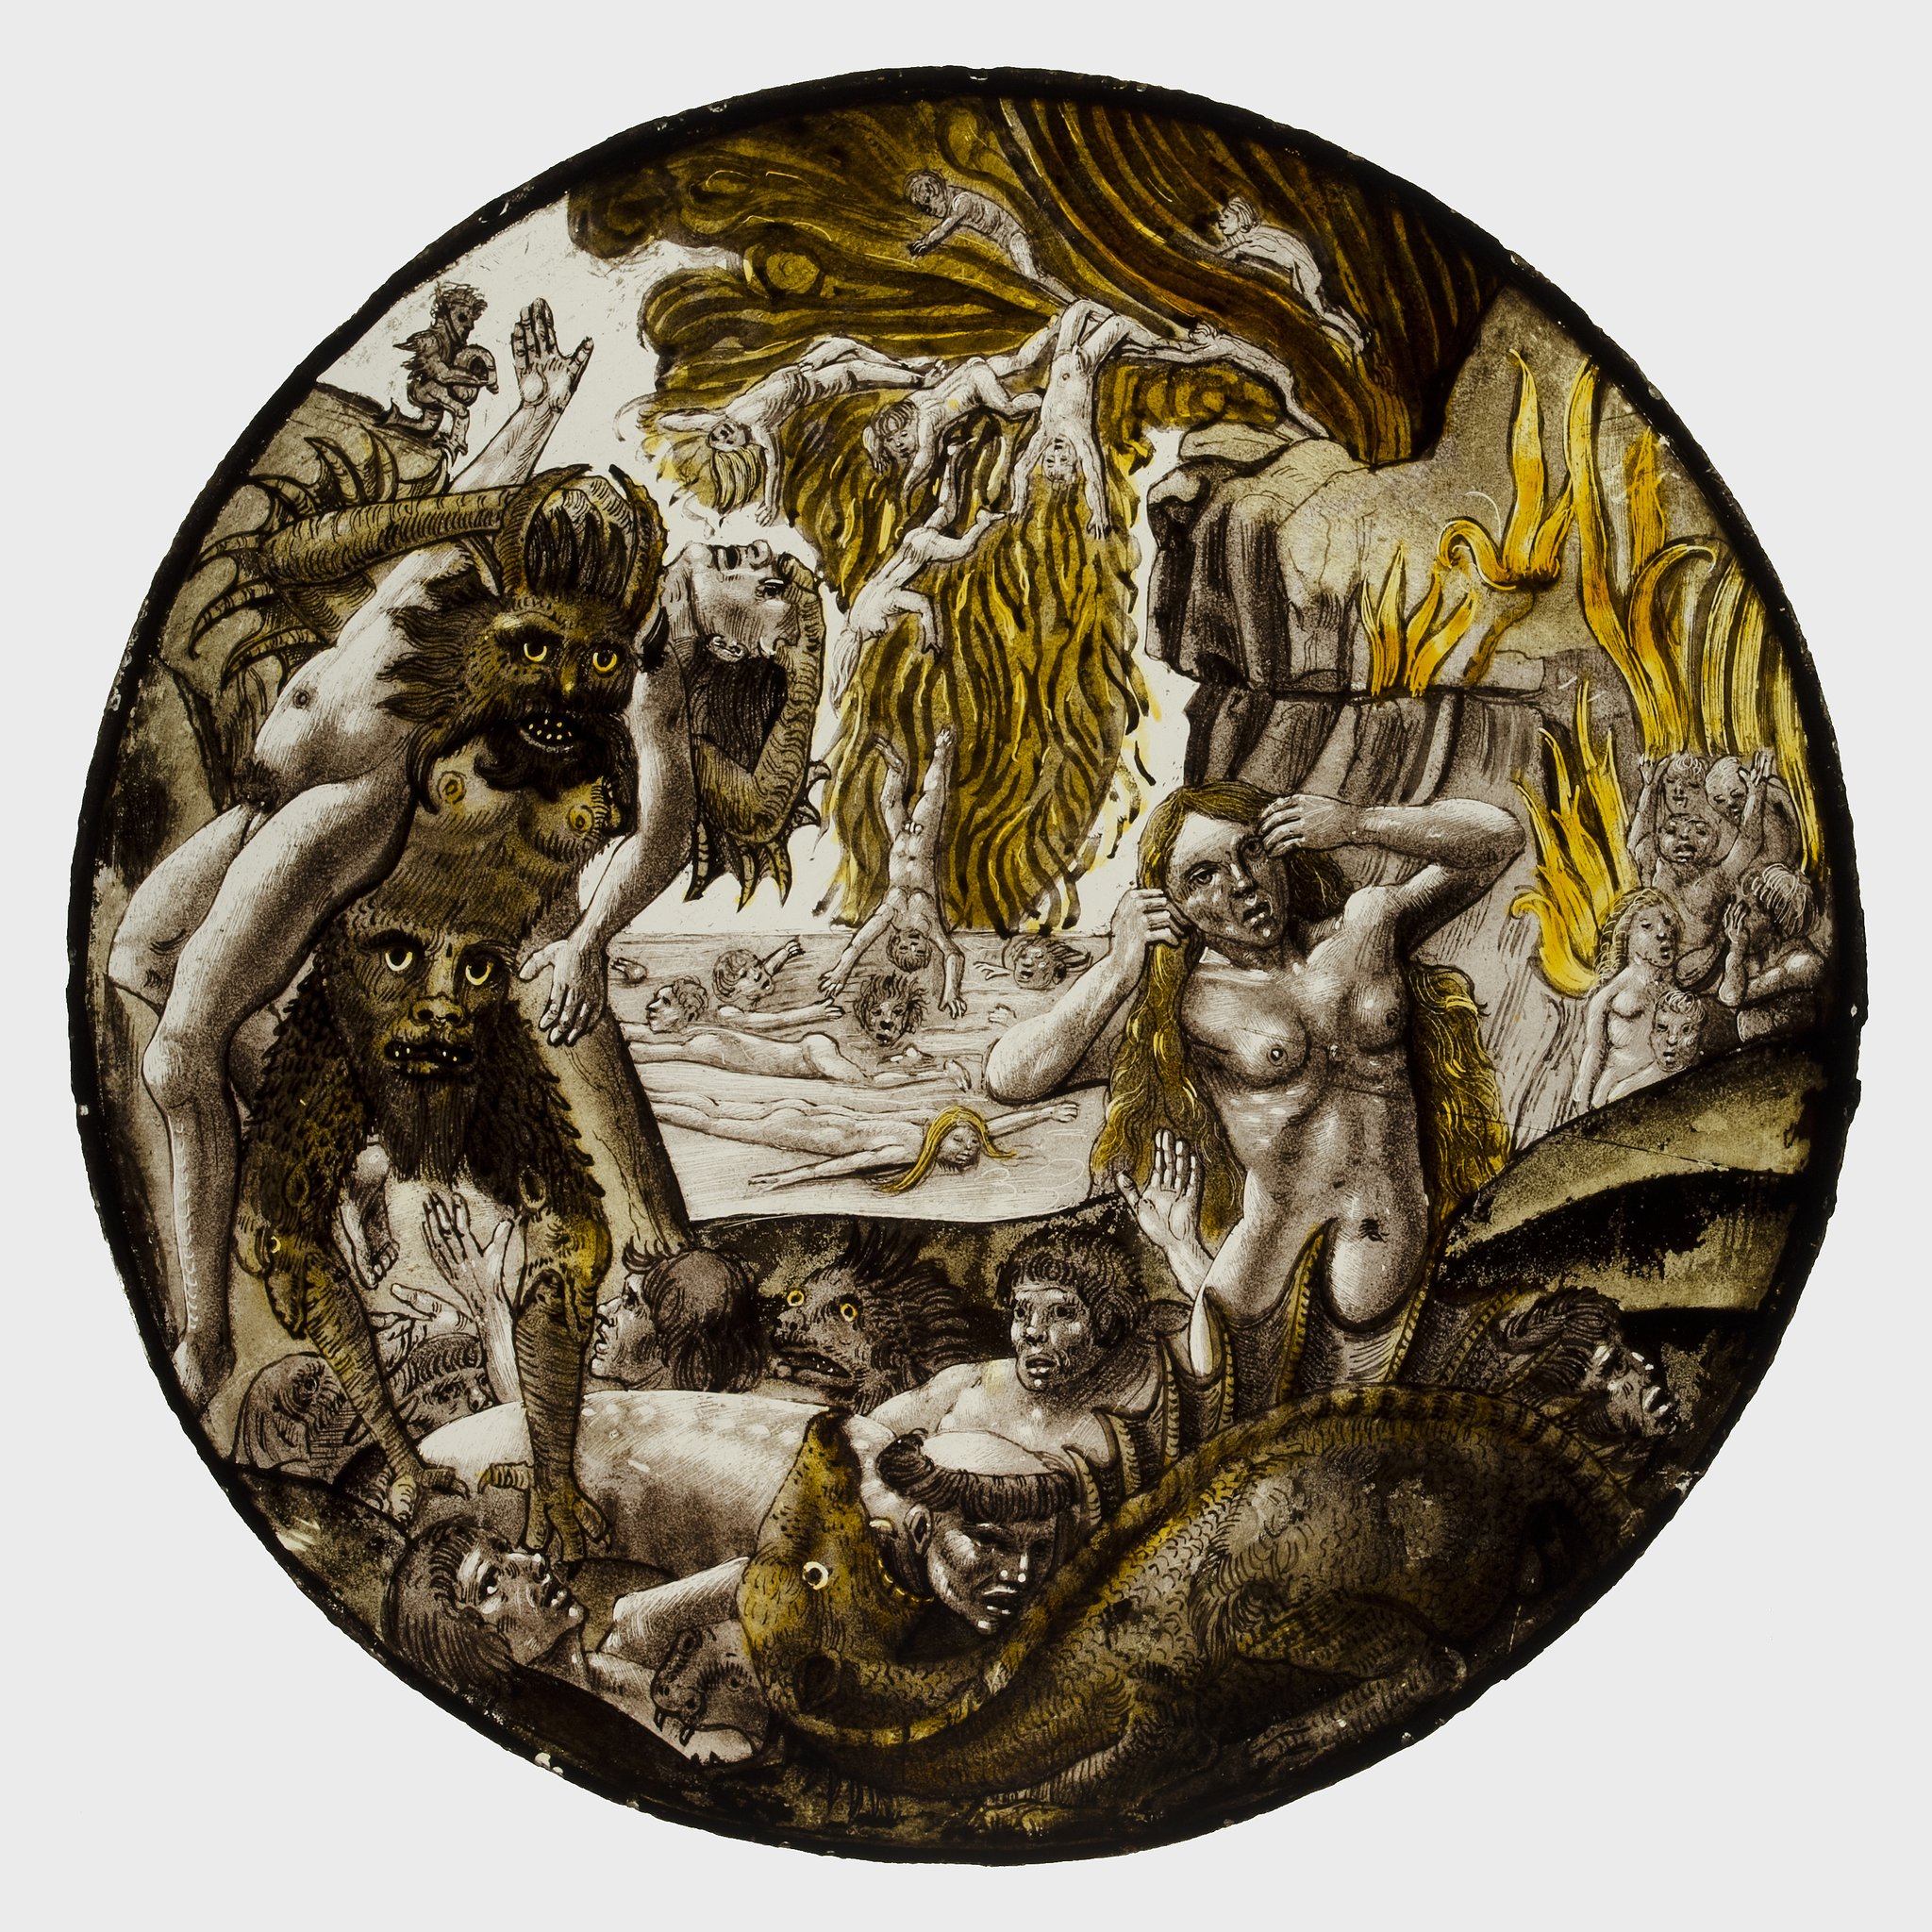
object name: roundel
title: Roundel with Souls Tormented in Hell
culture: south netherlandish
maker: dieric bouts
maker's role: artist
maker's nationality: netherlandish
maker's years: 1457-1475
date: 1500-1510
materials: glass, paint, pigment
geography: south netherlands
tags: suffering,female nudes,demons,hell